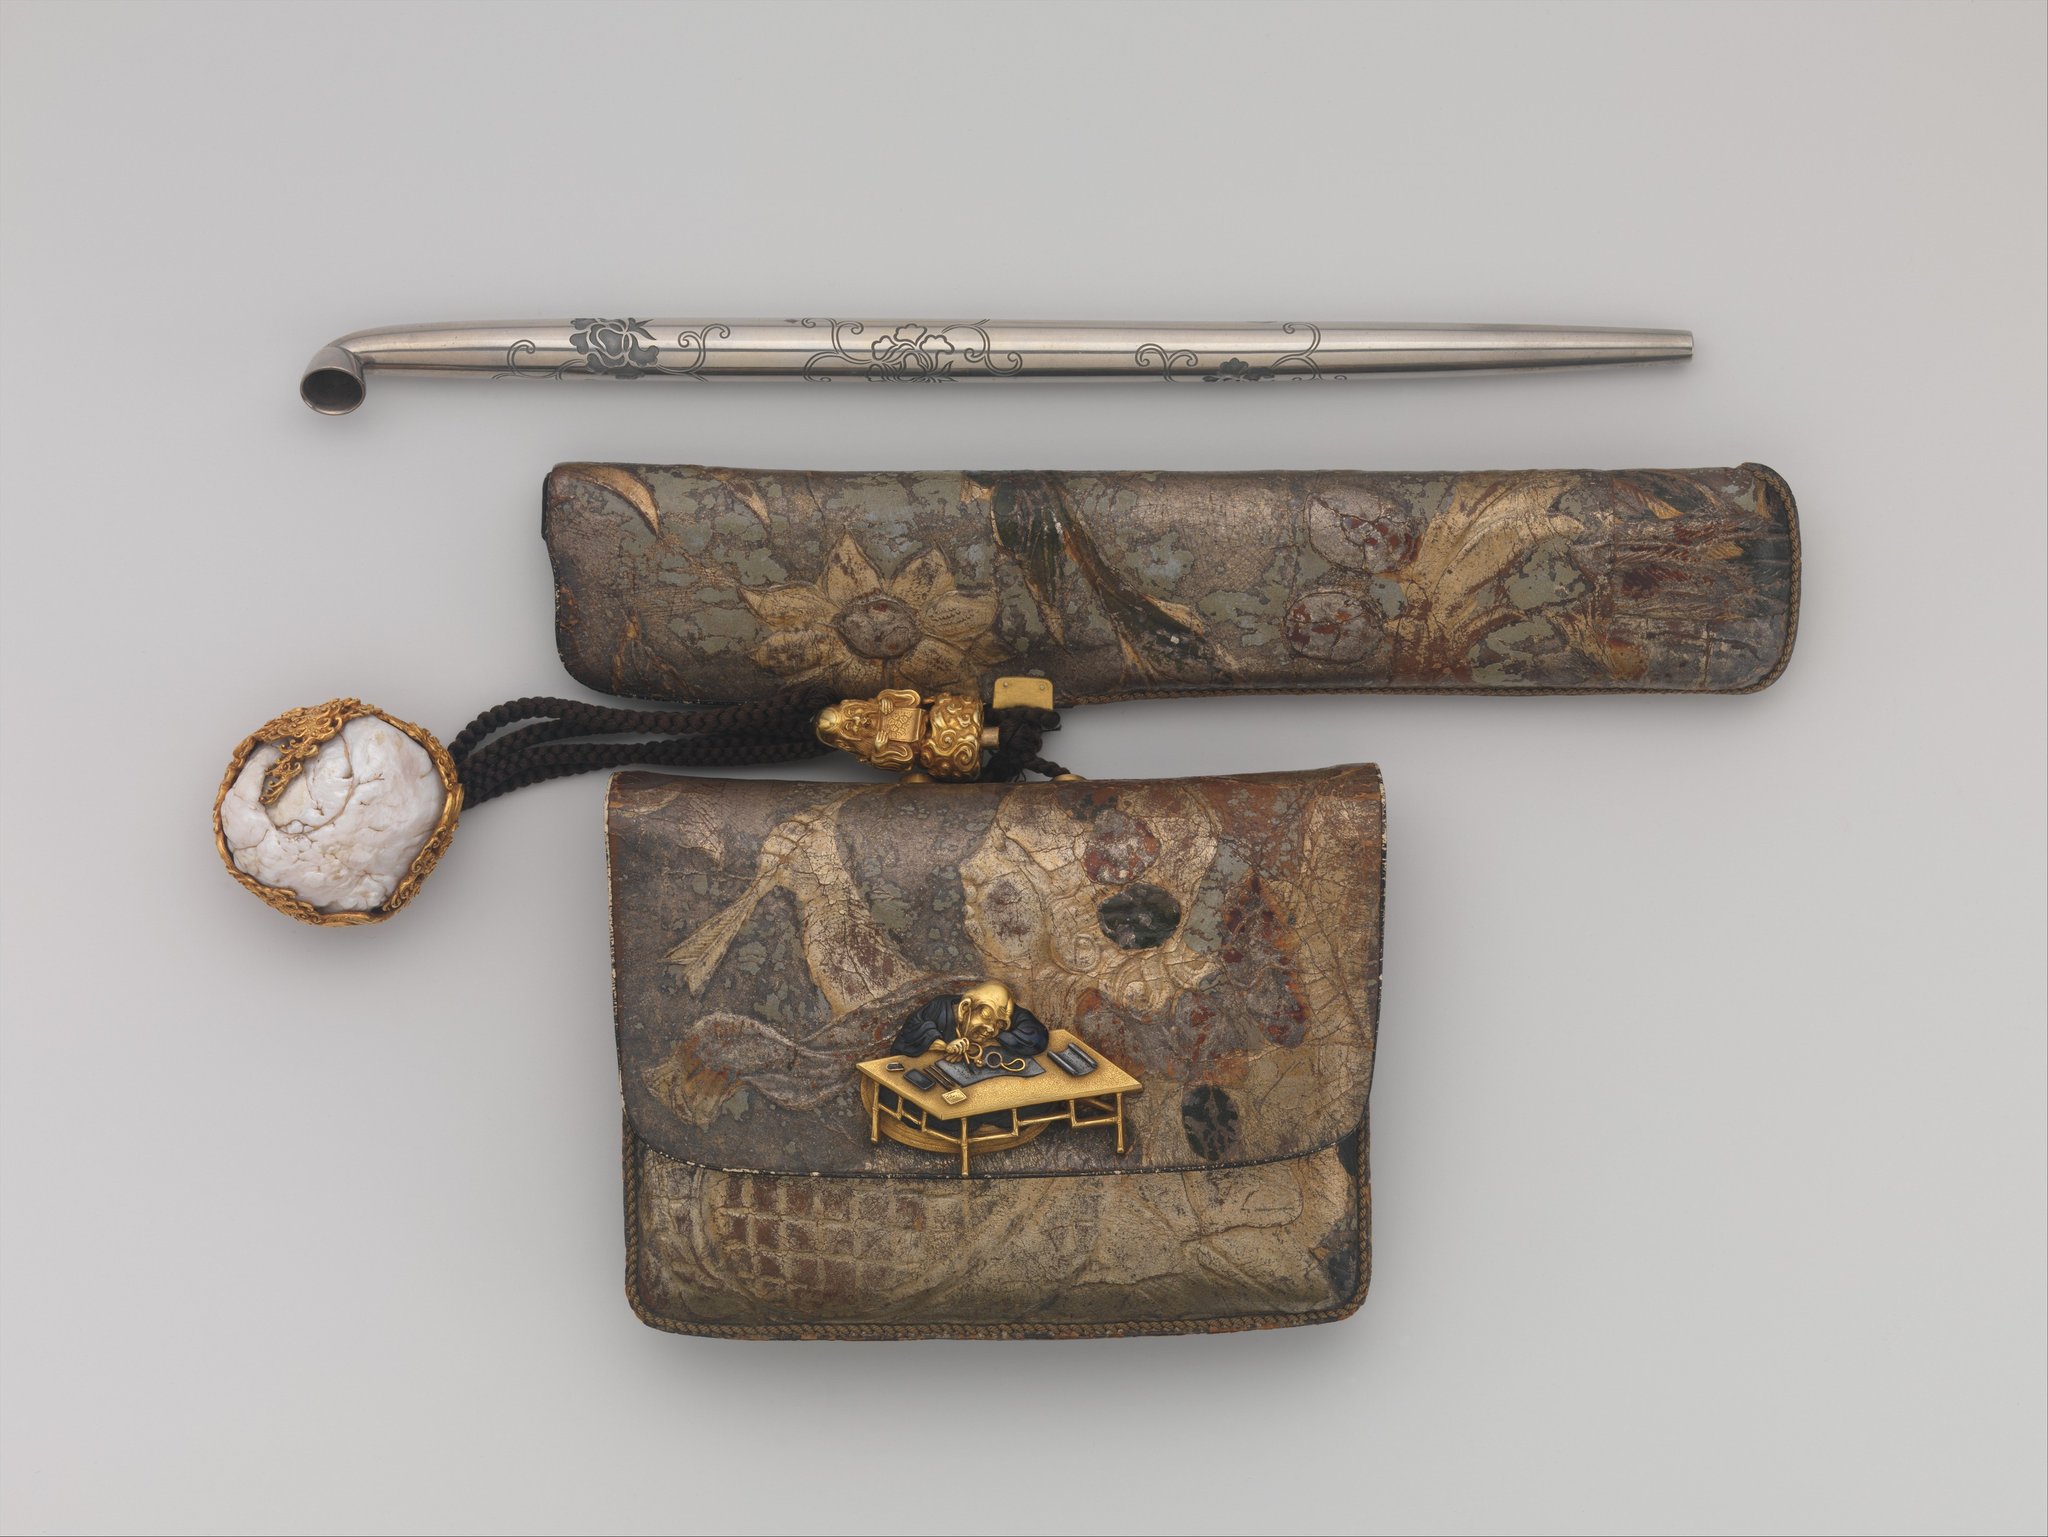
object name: tobacco pouch and pipe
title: Tobacco Pouch and Pipe with Netsuke of Freshwater Pearl in Gold Mount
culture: japanese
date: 1701-1800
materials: foil, gold, leather, metal, pearl, metal alloy, silver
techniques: embossing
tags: men,writing,desks